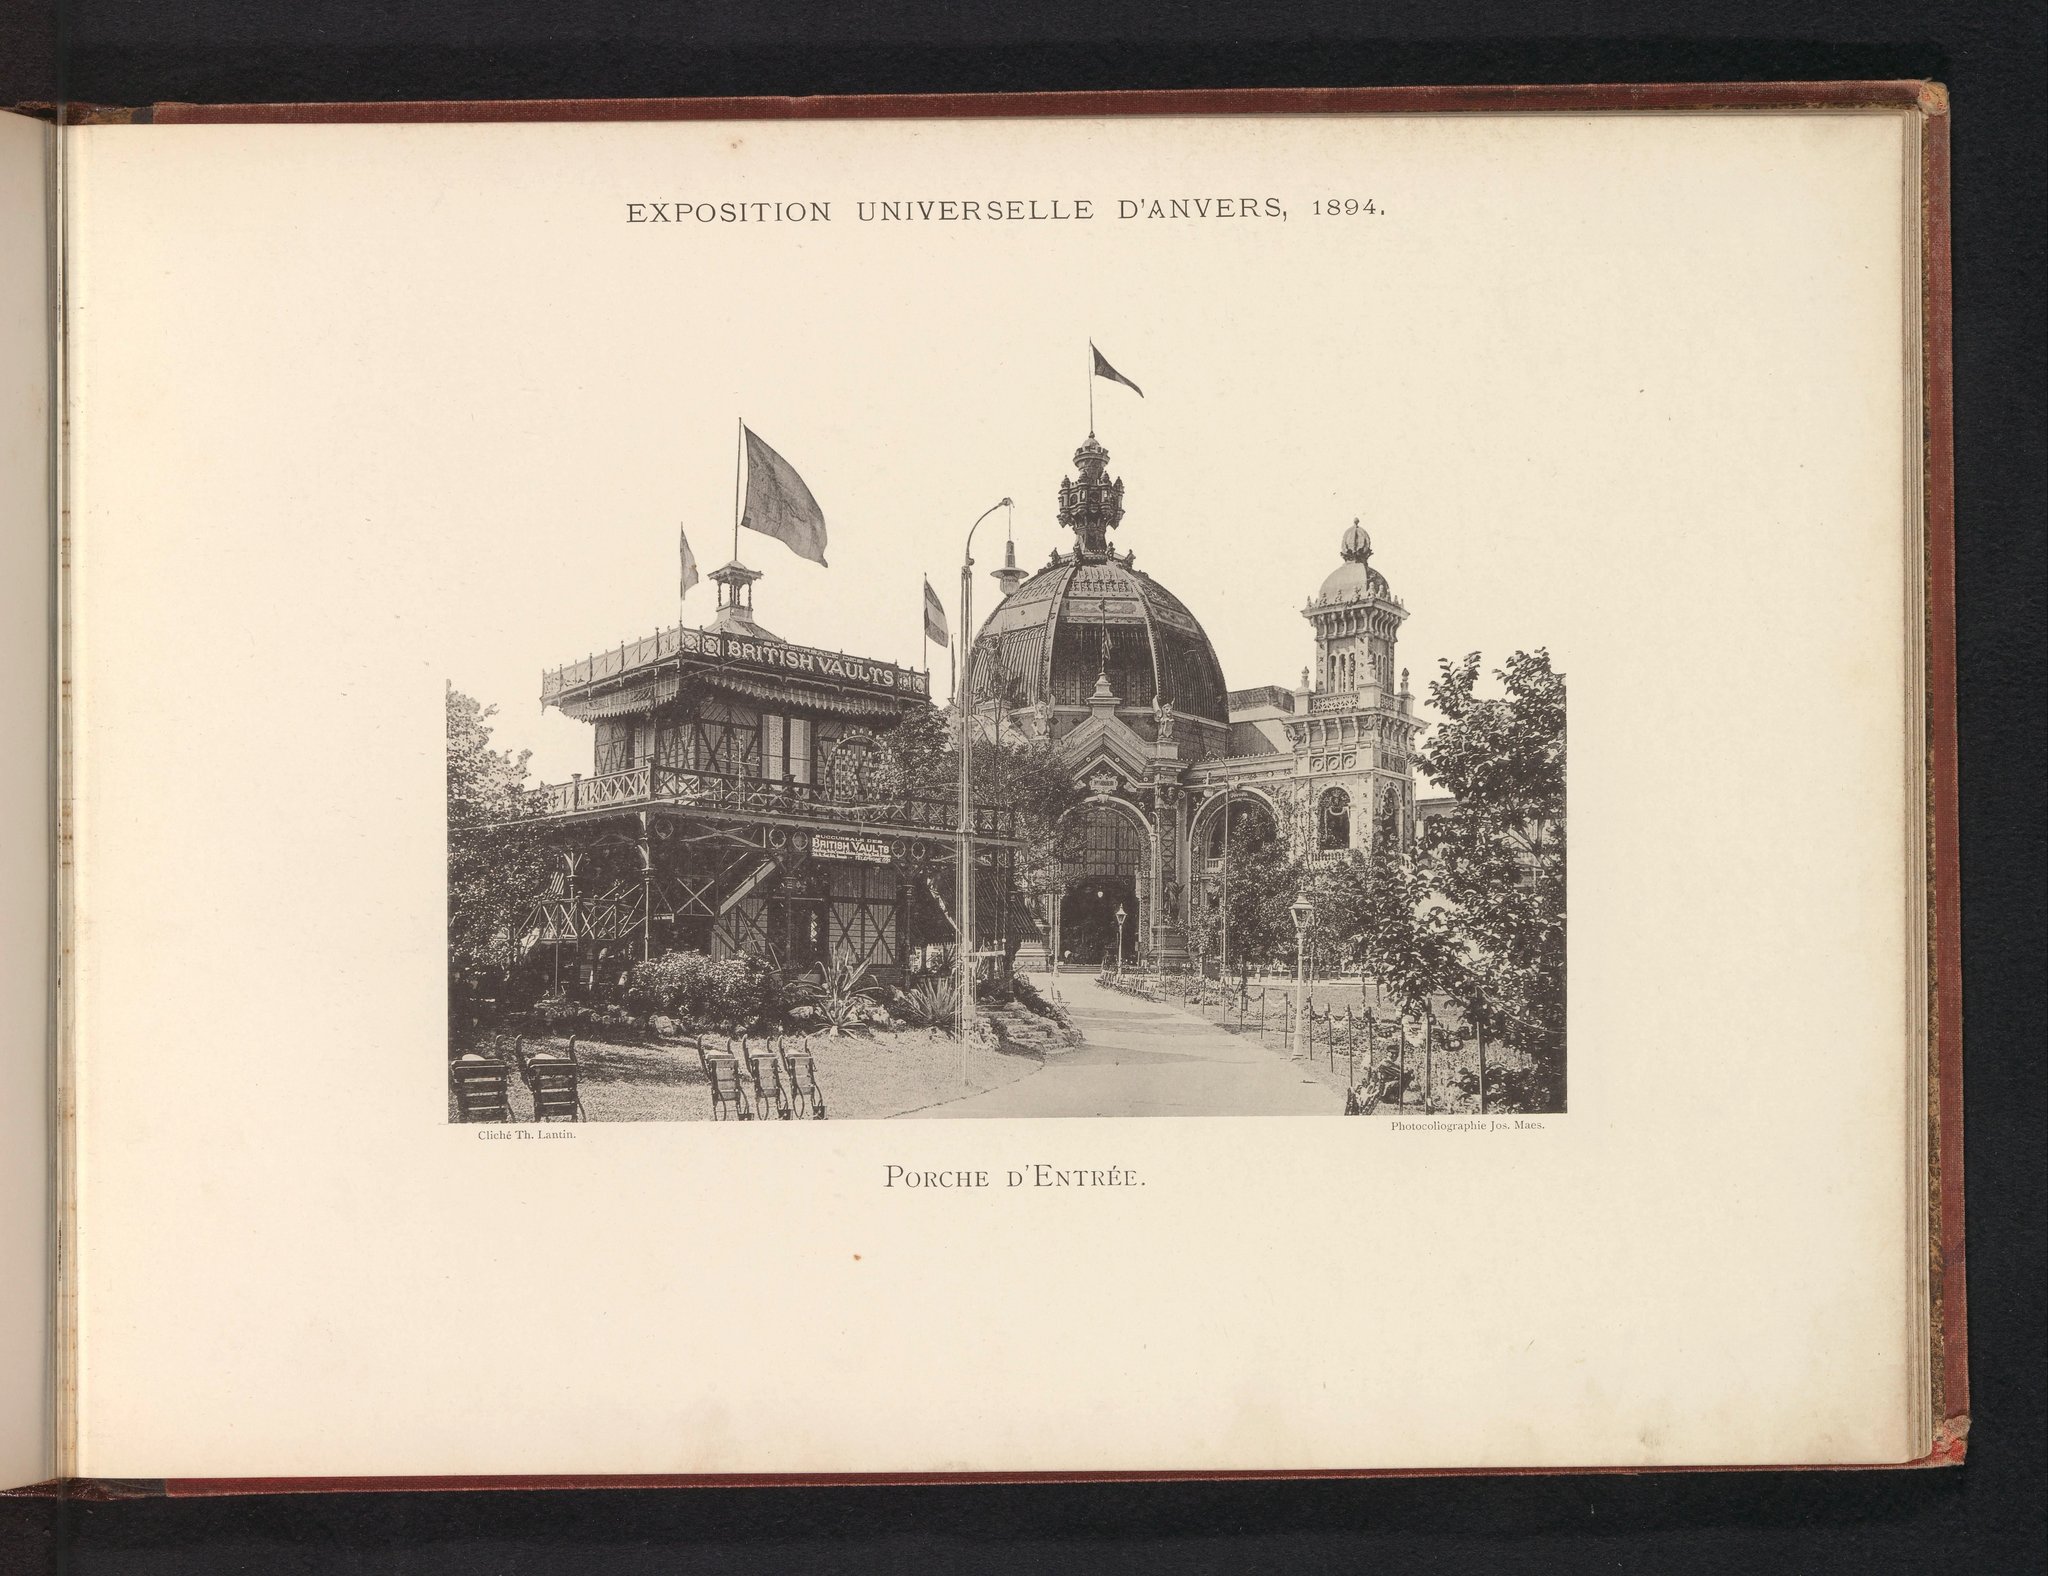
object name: photomechanical print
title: Porche d'entrée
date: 1894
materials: paper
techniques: photograph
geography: antwerp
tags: world fair, world exhibition, gate, entrance